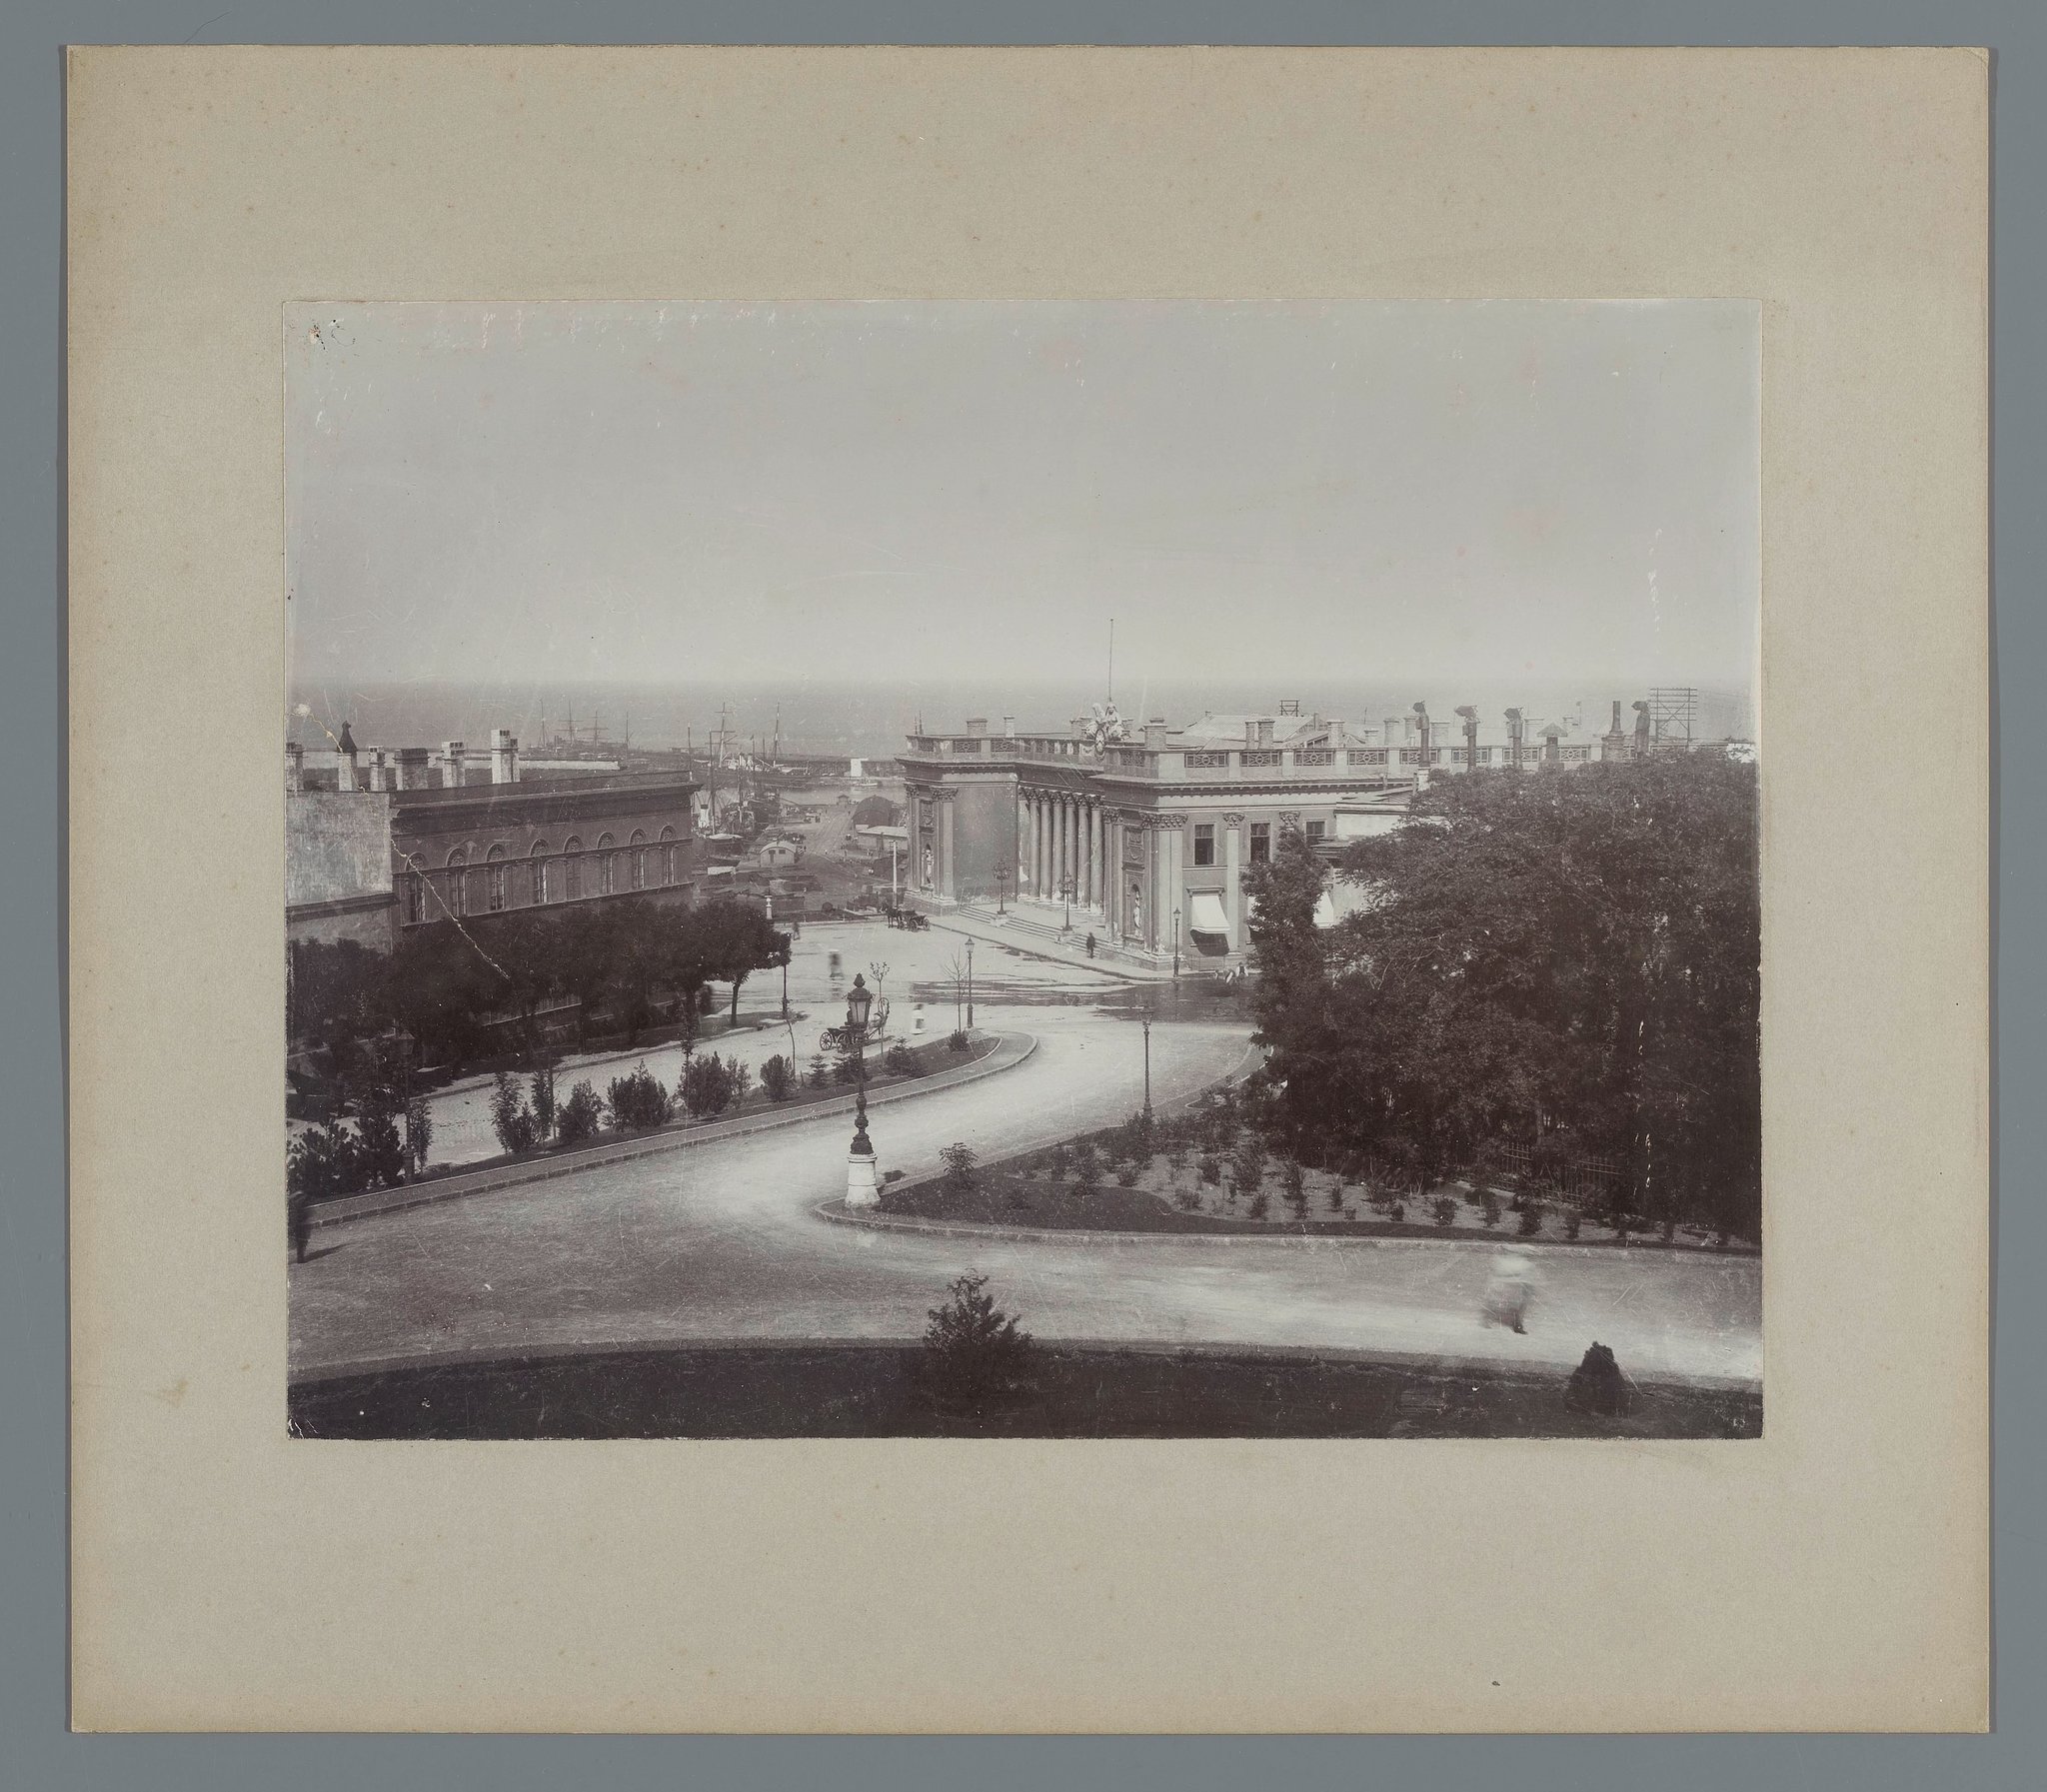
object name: photograph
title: Gebouwen aan een haven in Rusland, mogelijk in Sint-Petersburg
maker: Anonymous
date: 1880-1910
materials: paper, cardboard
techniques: collodion silver print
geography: sint-petersburg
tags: harbour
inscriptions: inscription: ‘Leningrad?’